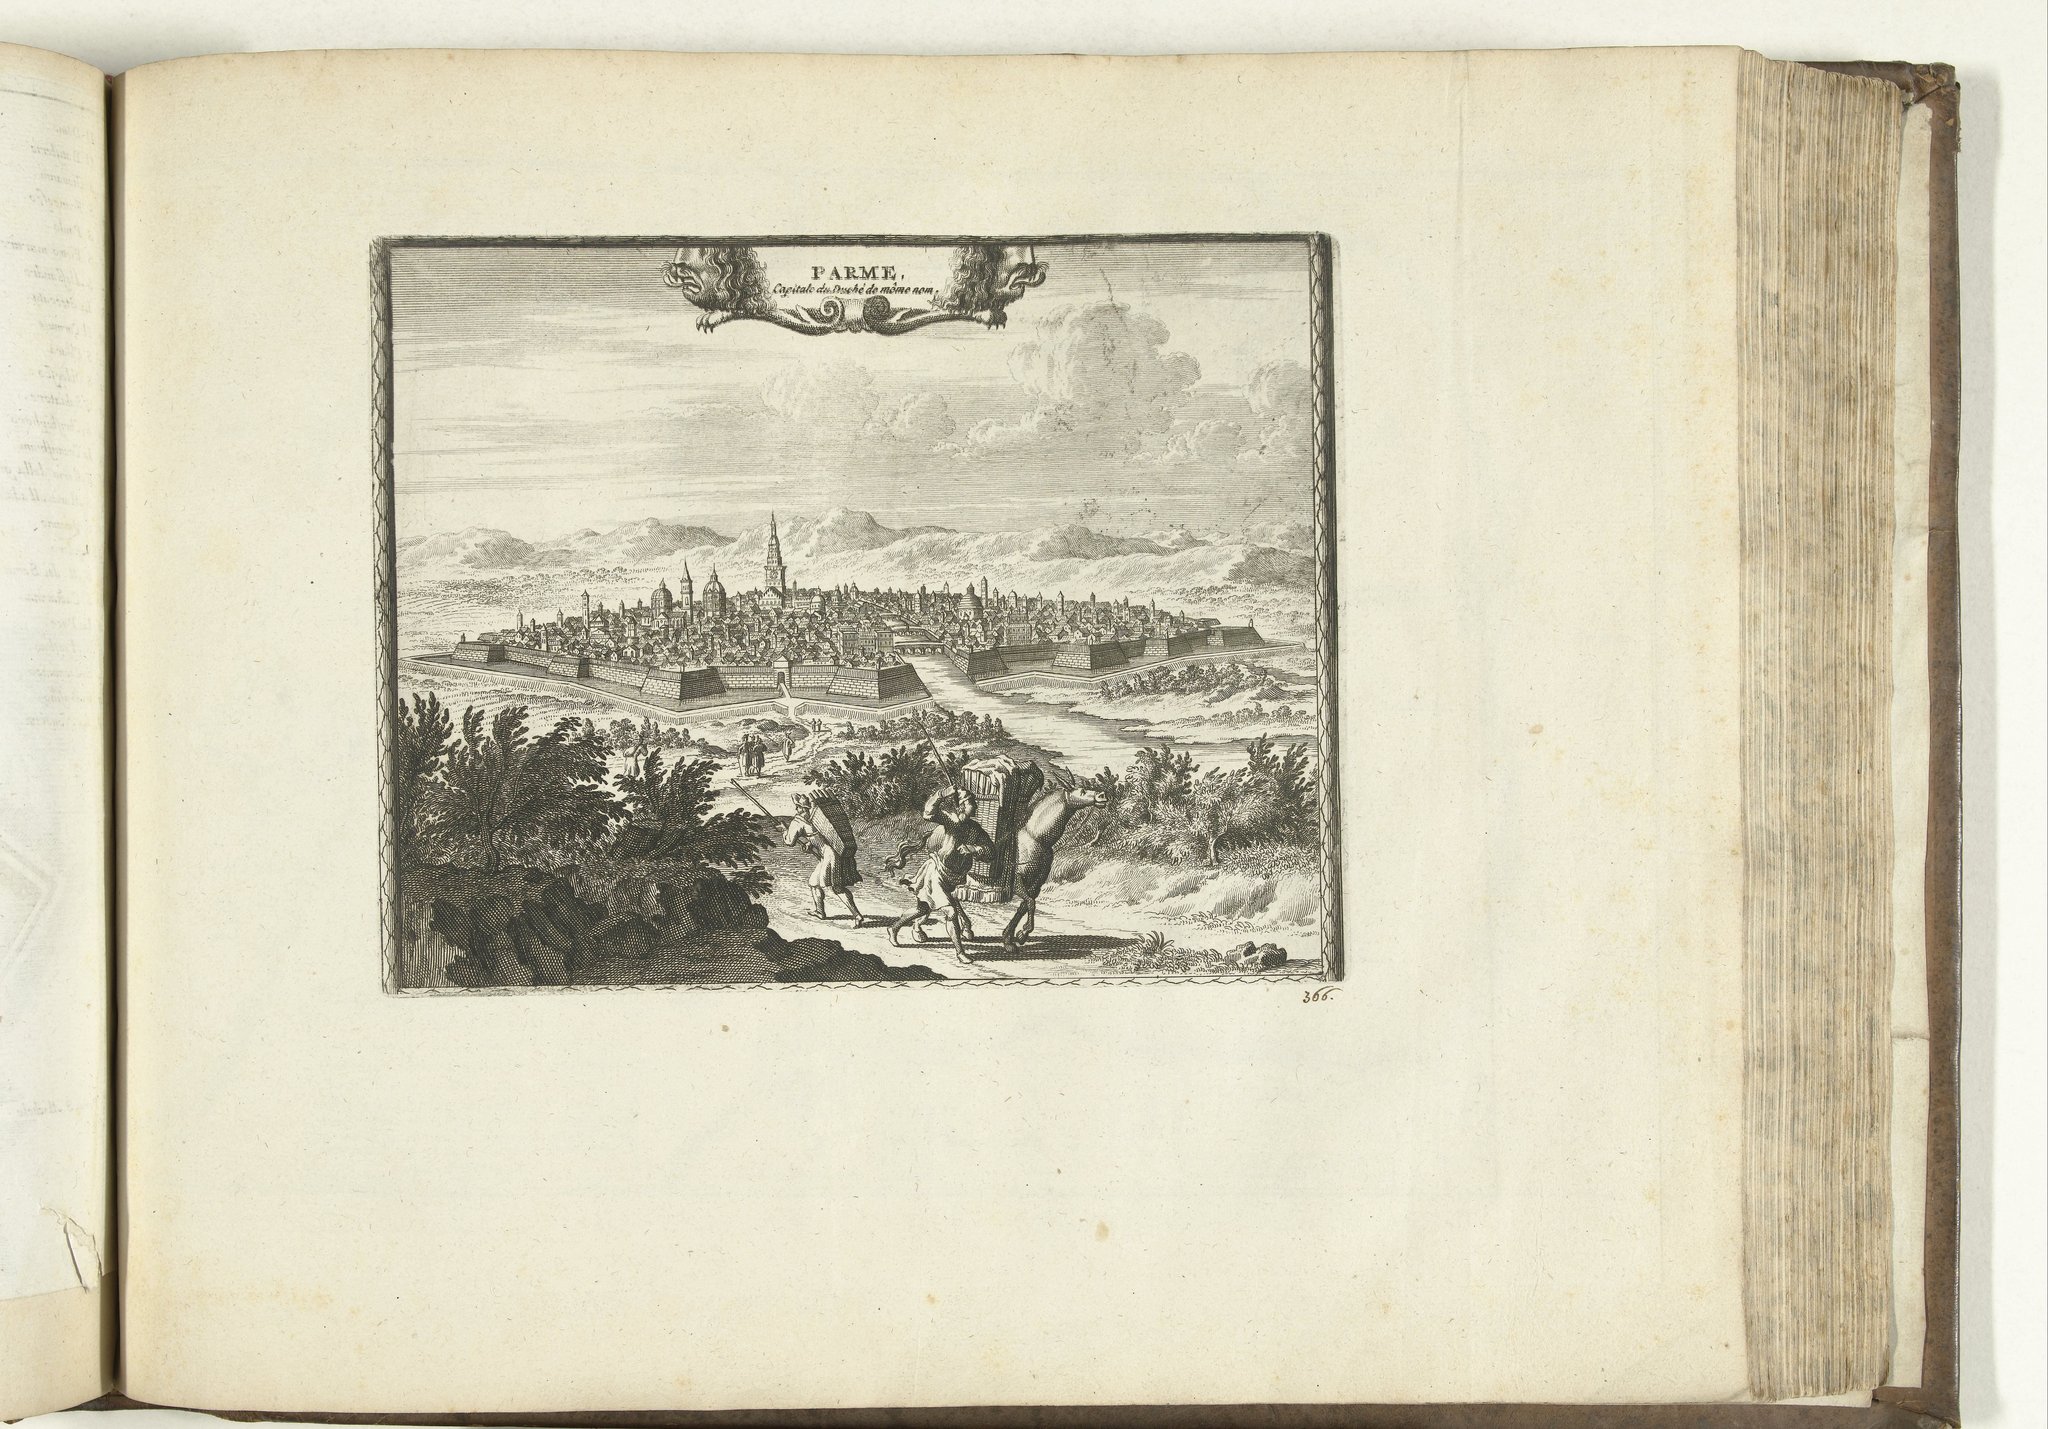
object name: print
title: Gezicht op Parma, 1726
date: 1726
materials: paper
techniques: etching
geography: leiden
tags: parma, spaanse successieoorlog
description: Gezicht op de Italiaanse stad Parma, op de voorgrond een muilezeldrijver. Plaat nr. 366 in deel XV van het prentwerk: Les Forces de l'Europe, Asie, Afrique et Amerique ... Comme aussi les Cartes des Côtes de France et d'Espagne uit 1726, dit tweede deel met 271 met de hand genummerde platen van vermaarde sterke steden en vestingen in het kader van de Spaanse Successieoorlog 1701-1713. Voor het merendeel zijn deze platen gekopieerd naar de anonieme Franse platen van vermaarde sterke steden en vestingen: in Les forces de l'Europe en in: Le theatre de la guerre, dans les Pays-Bas, beide oorspronkelijk uitgegeven door Nicolas de Fer te Parijs (1693-1697) in het kader van de Negenjarige Oorlog. Titel in het Frans.